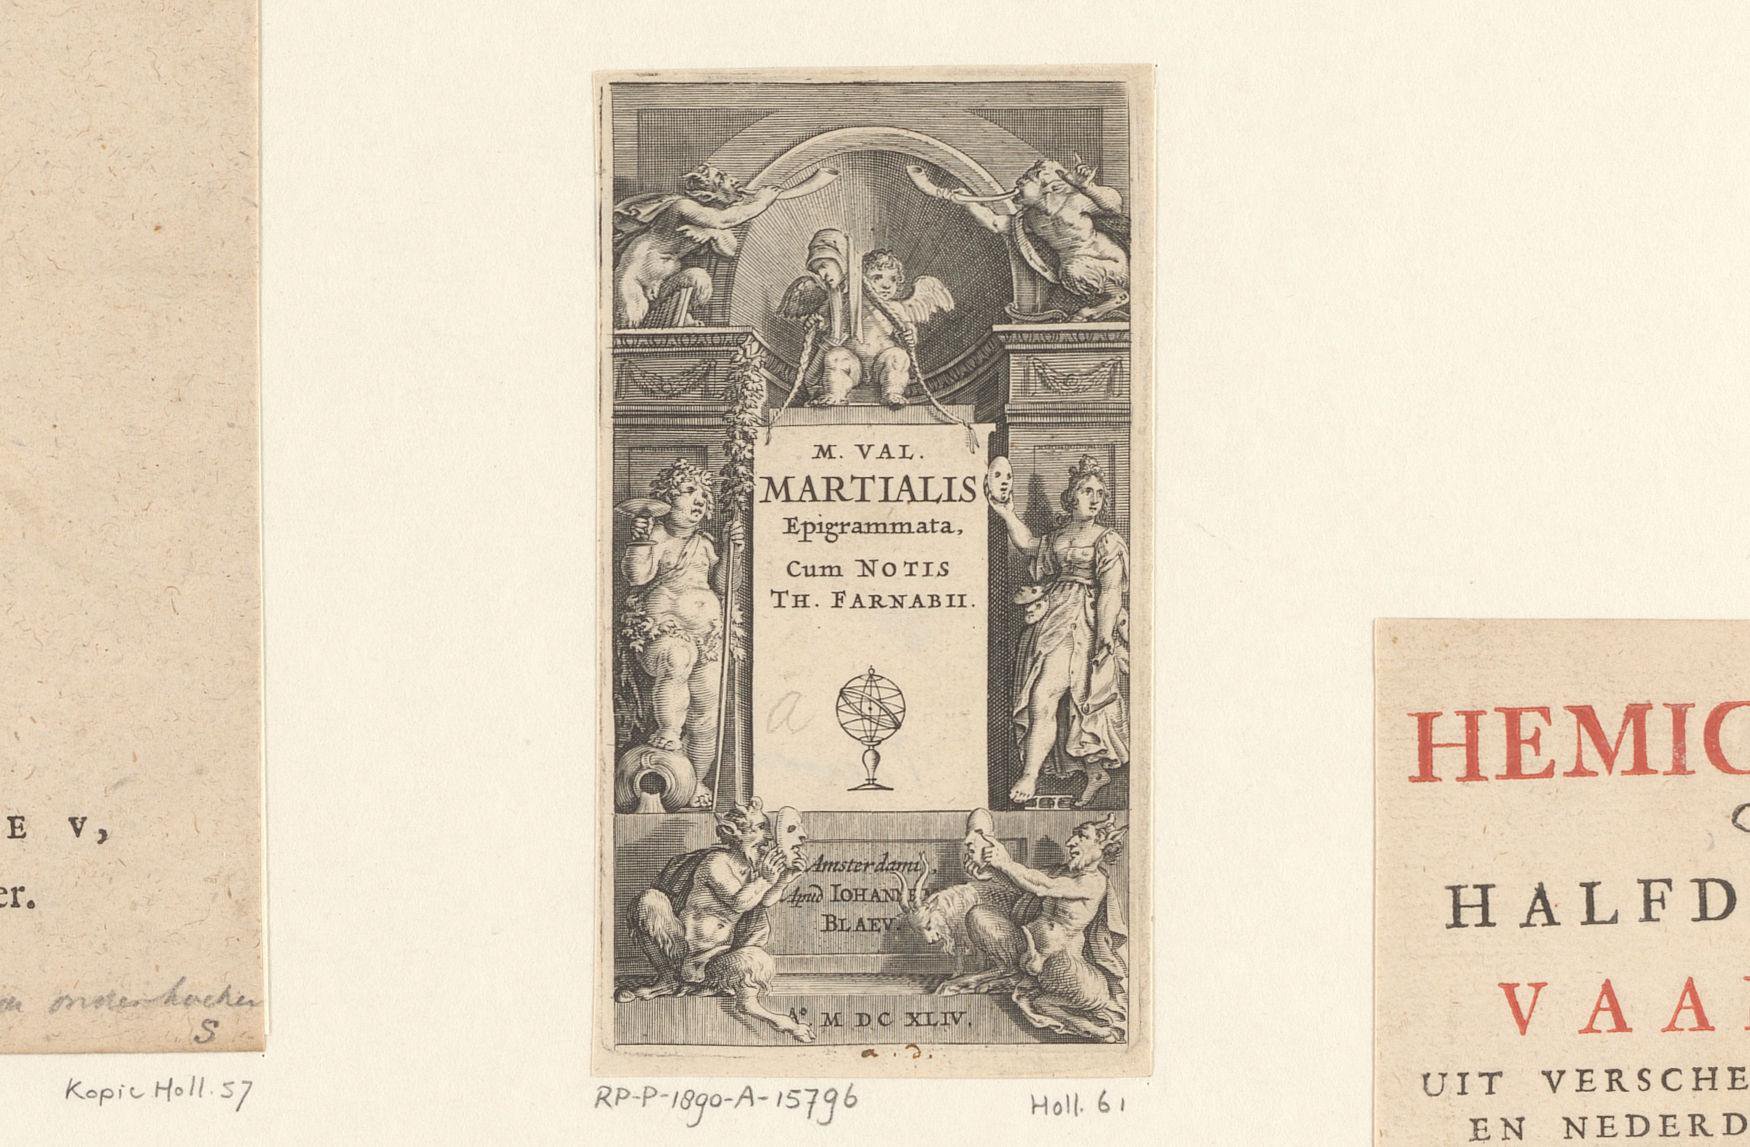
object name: print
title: Allegorische voorstelling van het toneel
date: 1644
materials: paper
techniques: engraving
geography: amsterdam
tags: mask, symbolic representations, allegories and emblems ~ the theatre, satyr(s) (in general), the drunken bacchus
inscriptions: inscription: ‘a.d.’, collector's mark: Lugt 2228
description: Rondom een tableau met daarop de titel en de auteur van het boek zitten saters met toneelmaskers en bazuinen. Rechtsonder een geit. Links staat Bacchus met een wijnstulk en een wijnglas, zijn voet op een leegstromende kruik. Rechts staat een vrouw met toneelmaskers en een rol papier in de hand.